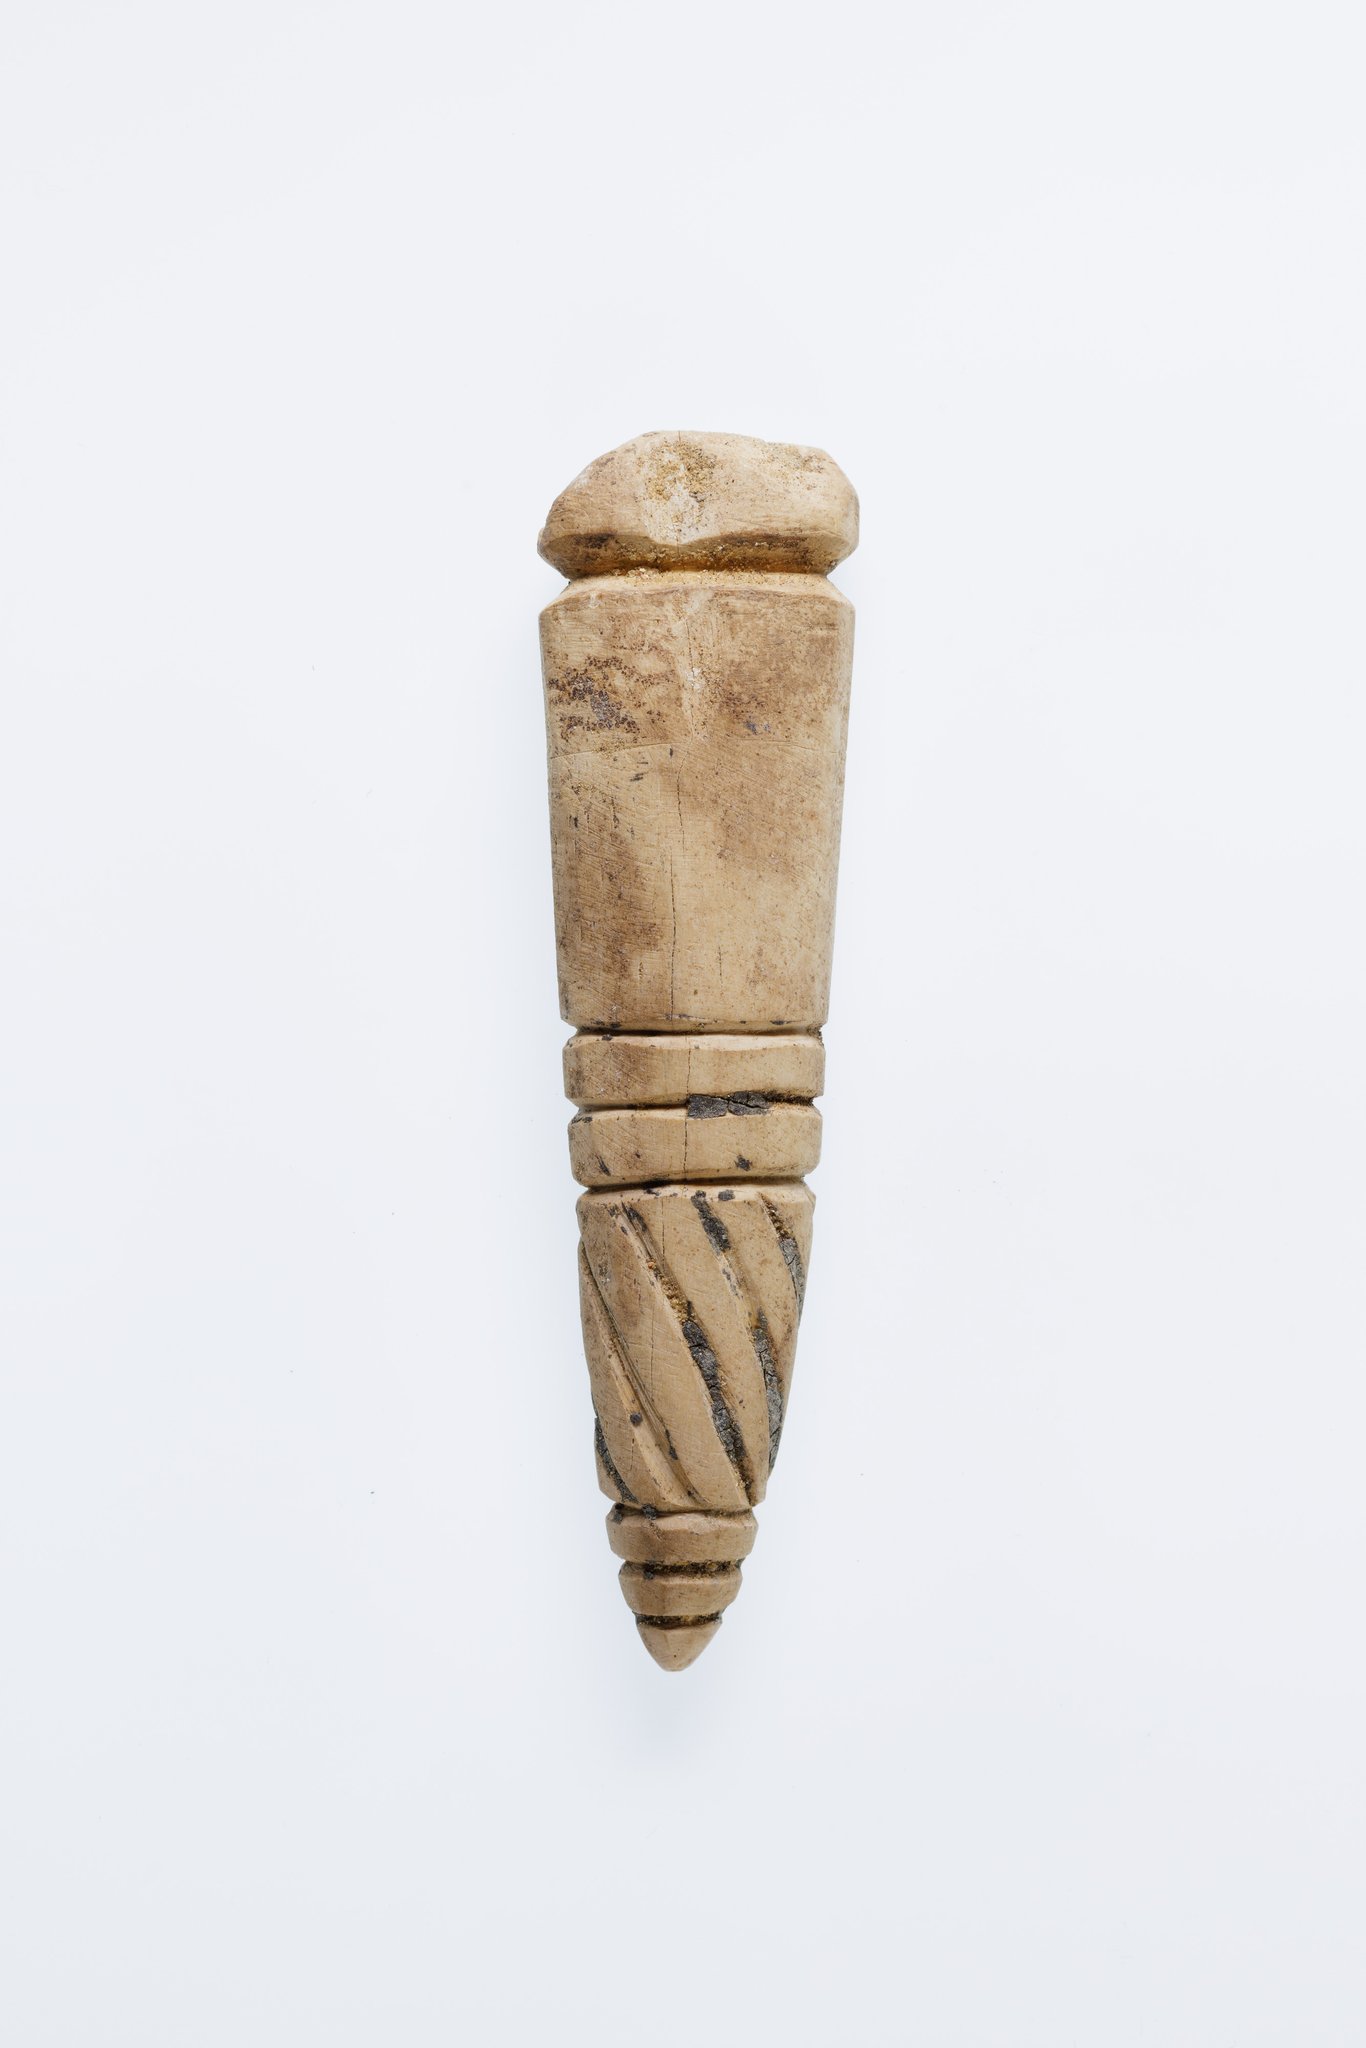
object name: amulet, tag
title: Tag amulet in the form of a tusk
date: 3900-3650 BCE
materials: ivory, paste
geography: egypt